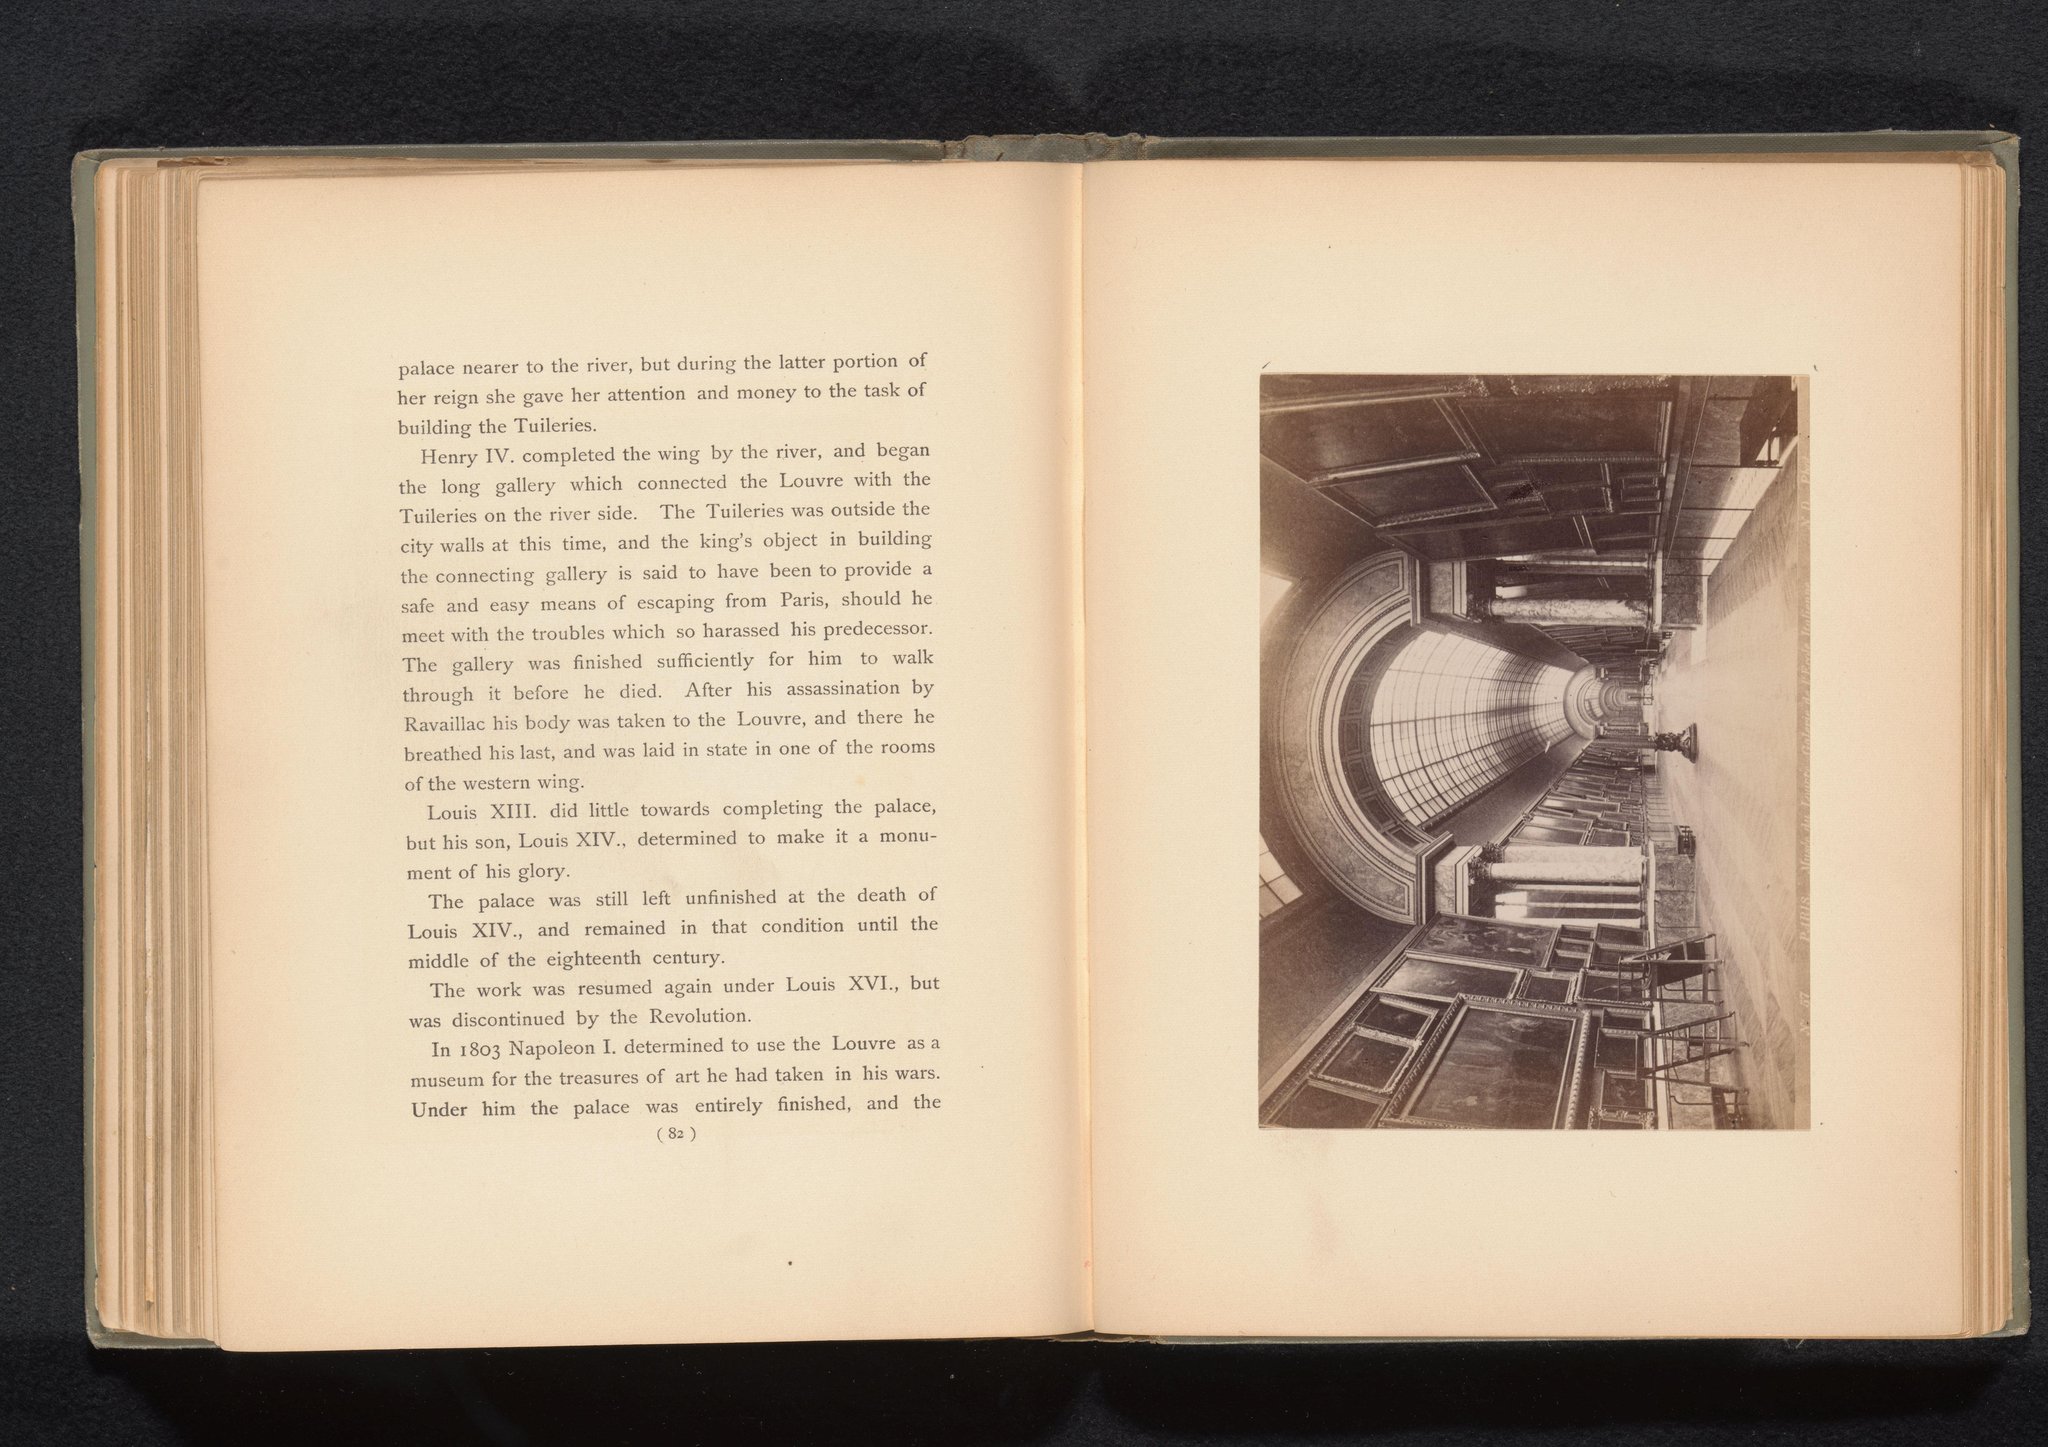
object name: photograph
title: Paris. Musée du Louvre. Galerie d'École Italienne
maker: étienne neurdein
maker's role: publisher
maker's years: 1832-1918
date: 1882-1887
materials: photographic support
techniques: albumen print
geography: louvre museum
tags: permanent exhibition, museum, interior ~ representation of a building